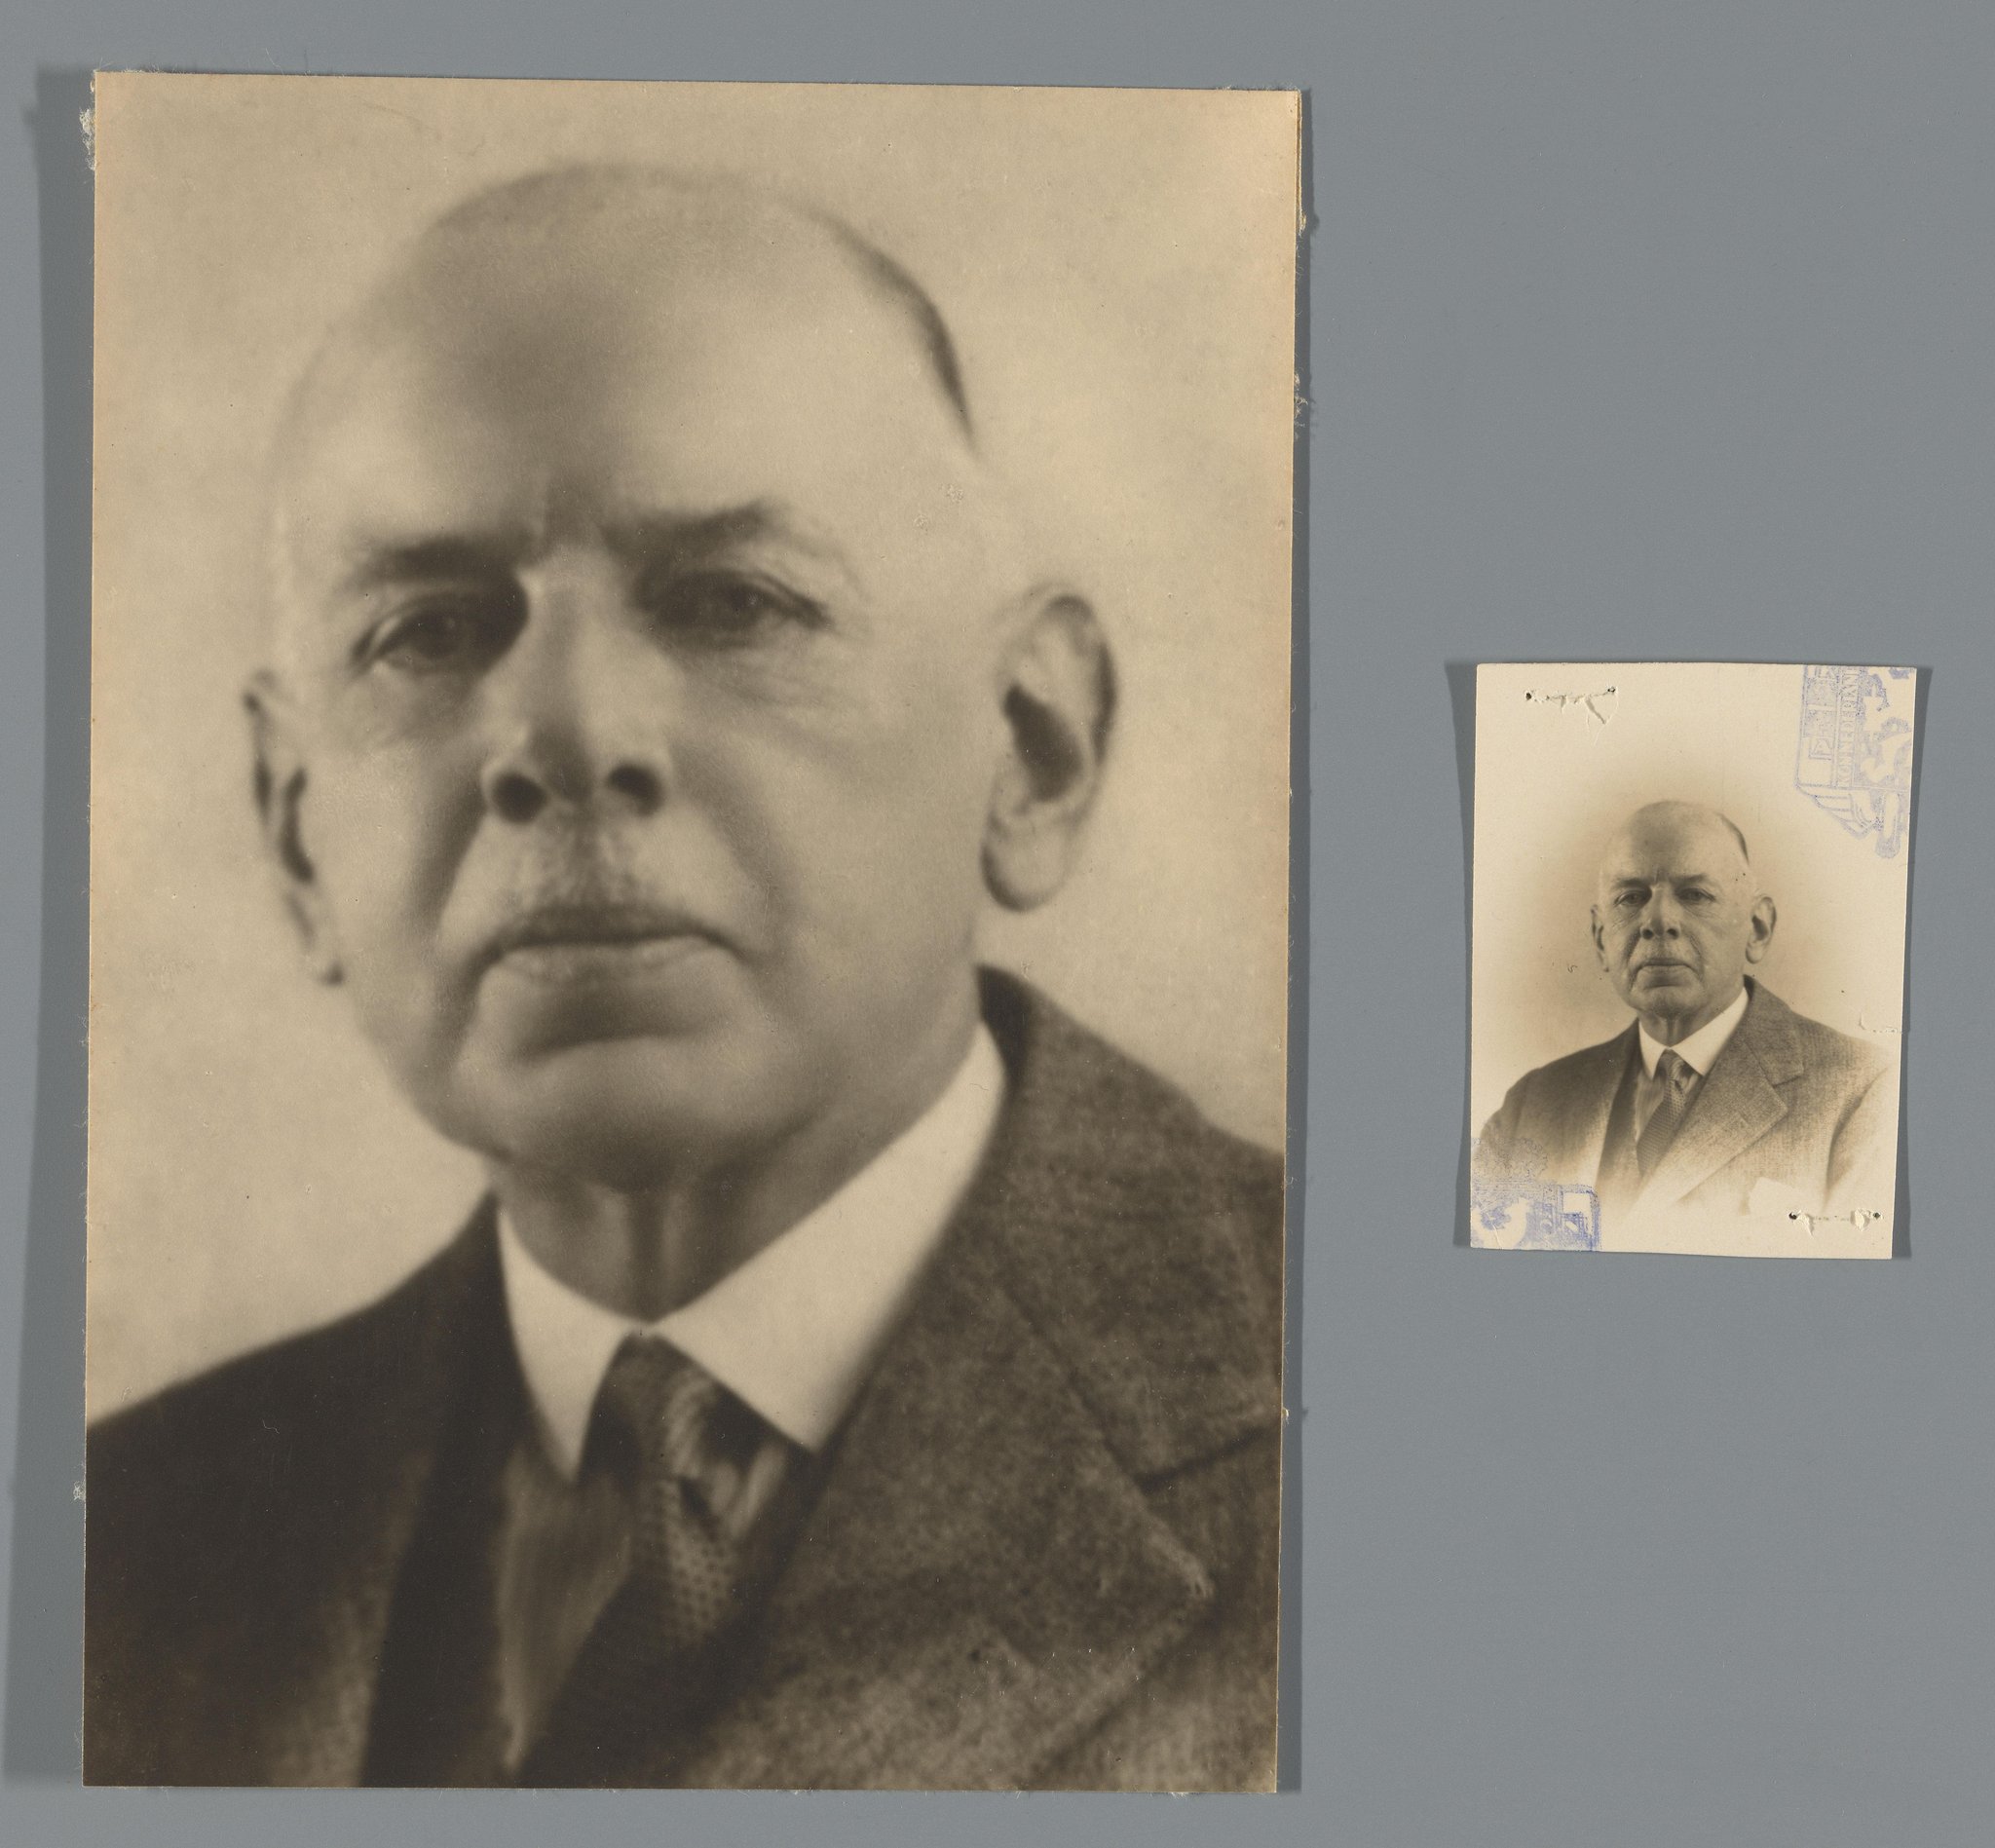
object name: passport photograph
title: Portret van Karel Frederik van den Berg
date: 1938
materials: photographic support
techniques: photography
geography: amsterdam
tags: batavia, karel frederik van den berg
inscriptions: inscription: ‘K.F. van den Berg / volgens pasfoto / 23 mei 1938 / den Haag’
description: Verso een pasfoto van dezelfde opname met fragmenten van blauwe stempels.